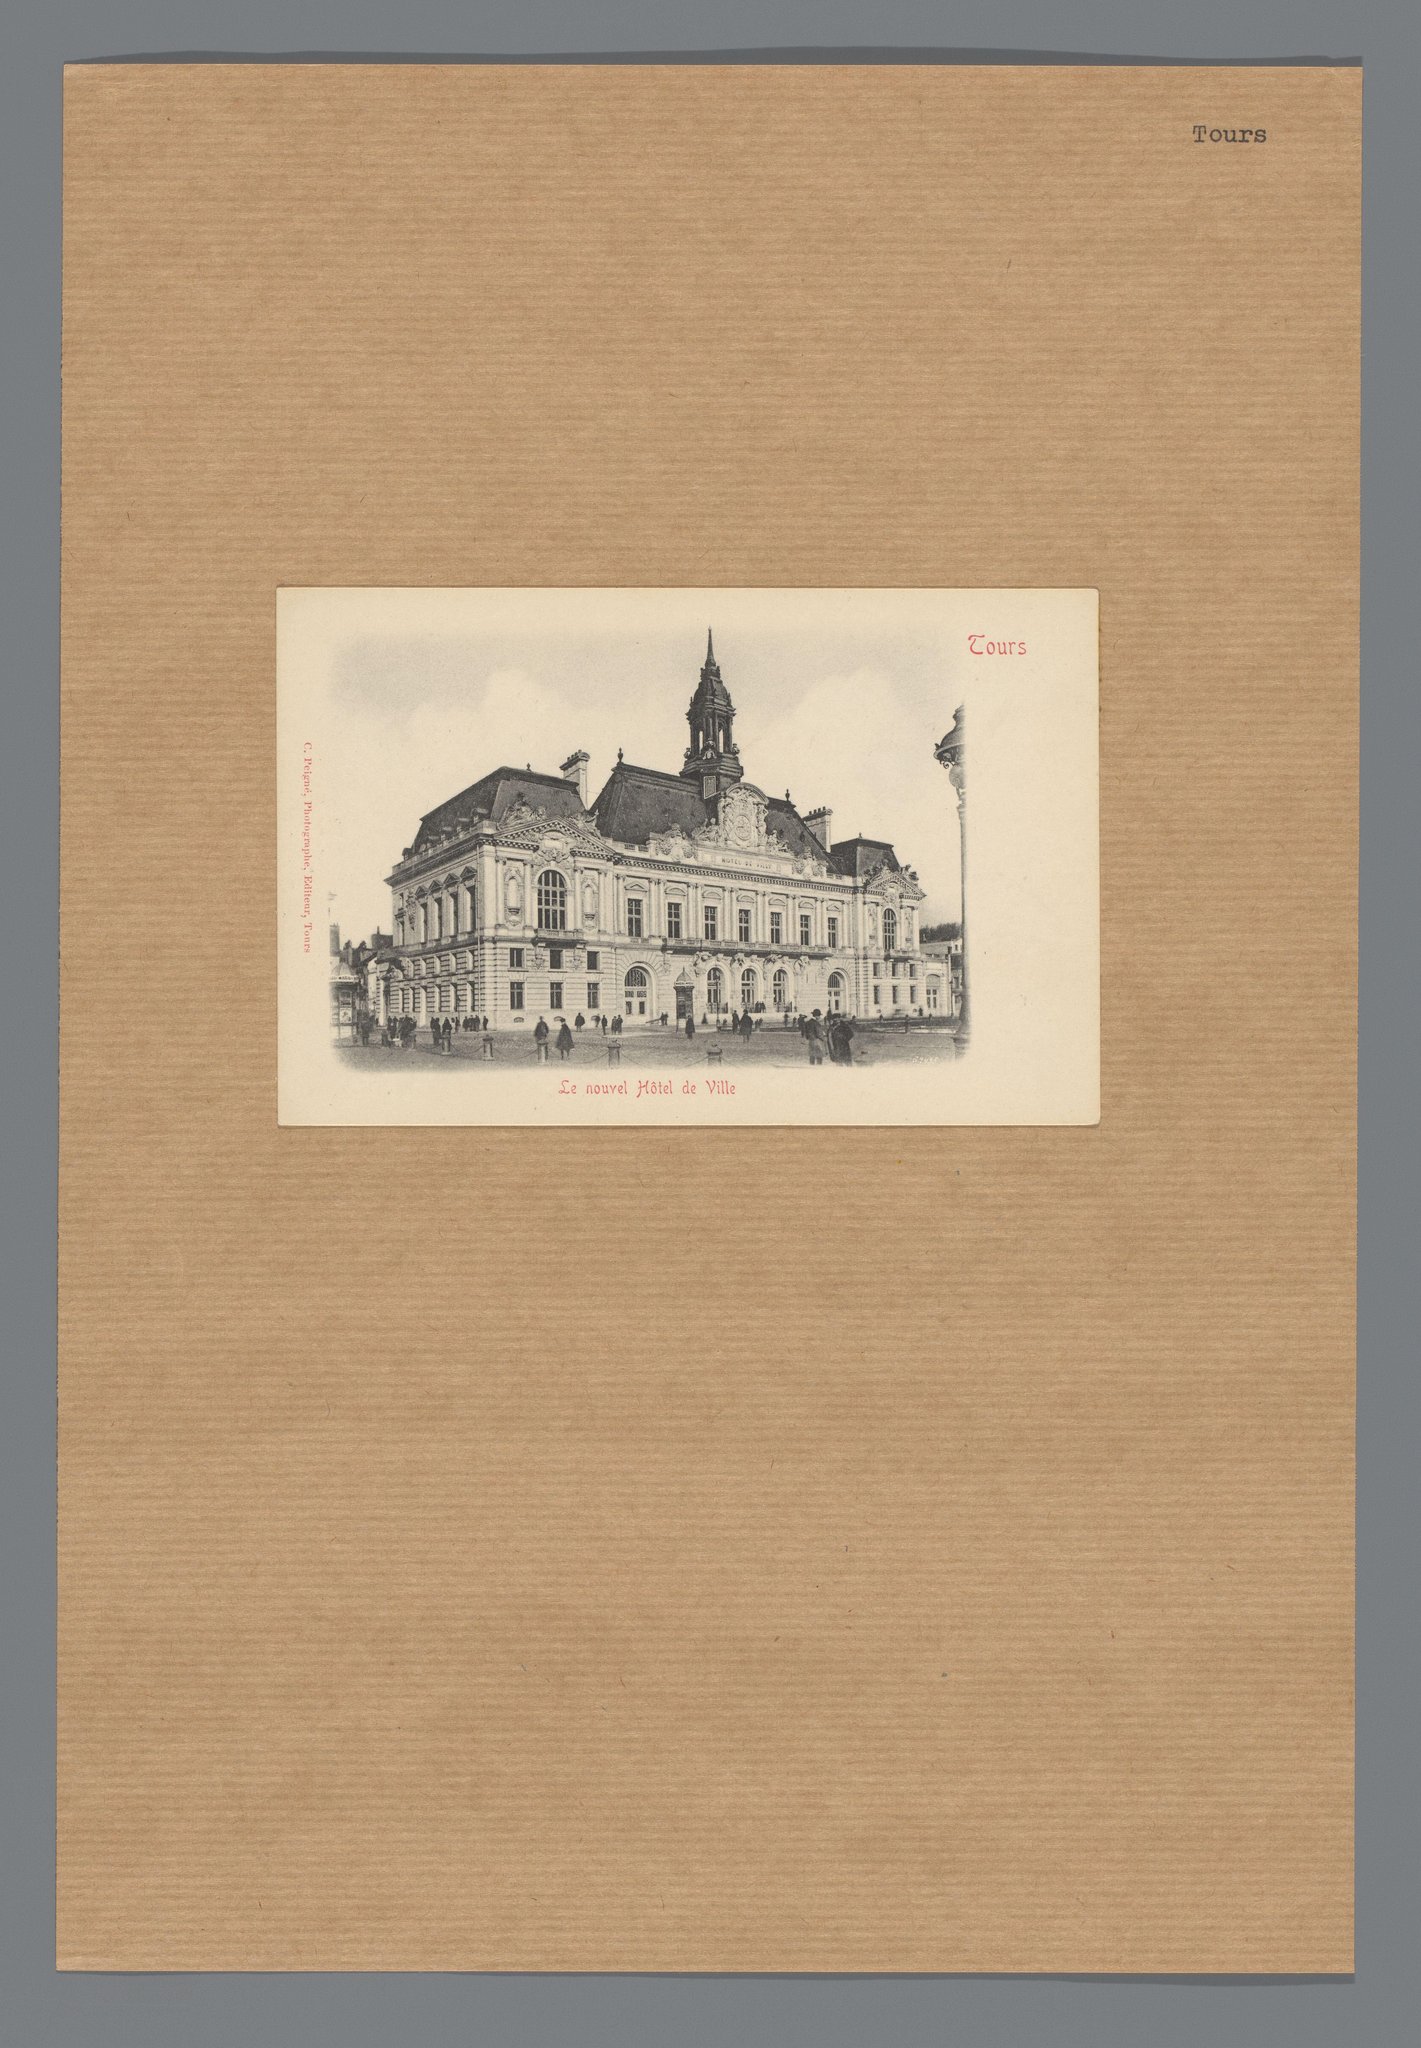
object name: photograph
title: Tours. Nouvel Hotel de Ville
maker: Anonymous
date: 1860-1925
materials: paper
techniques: photograph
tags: tours